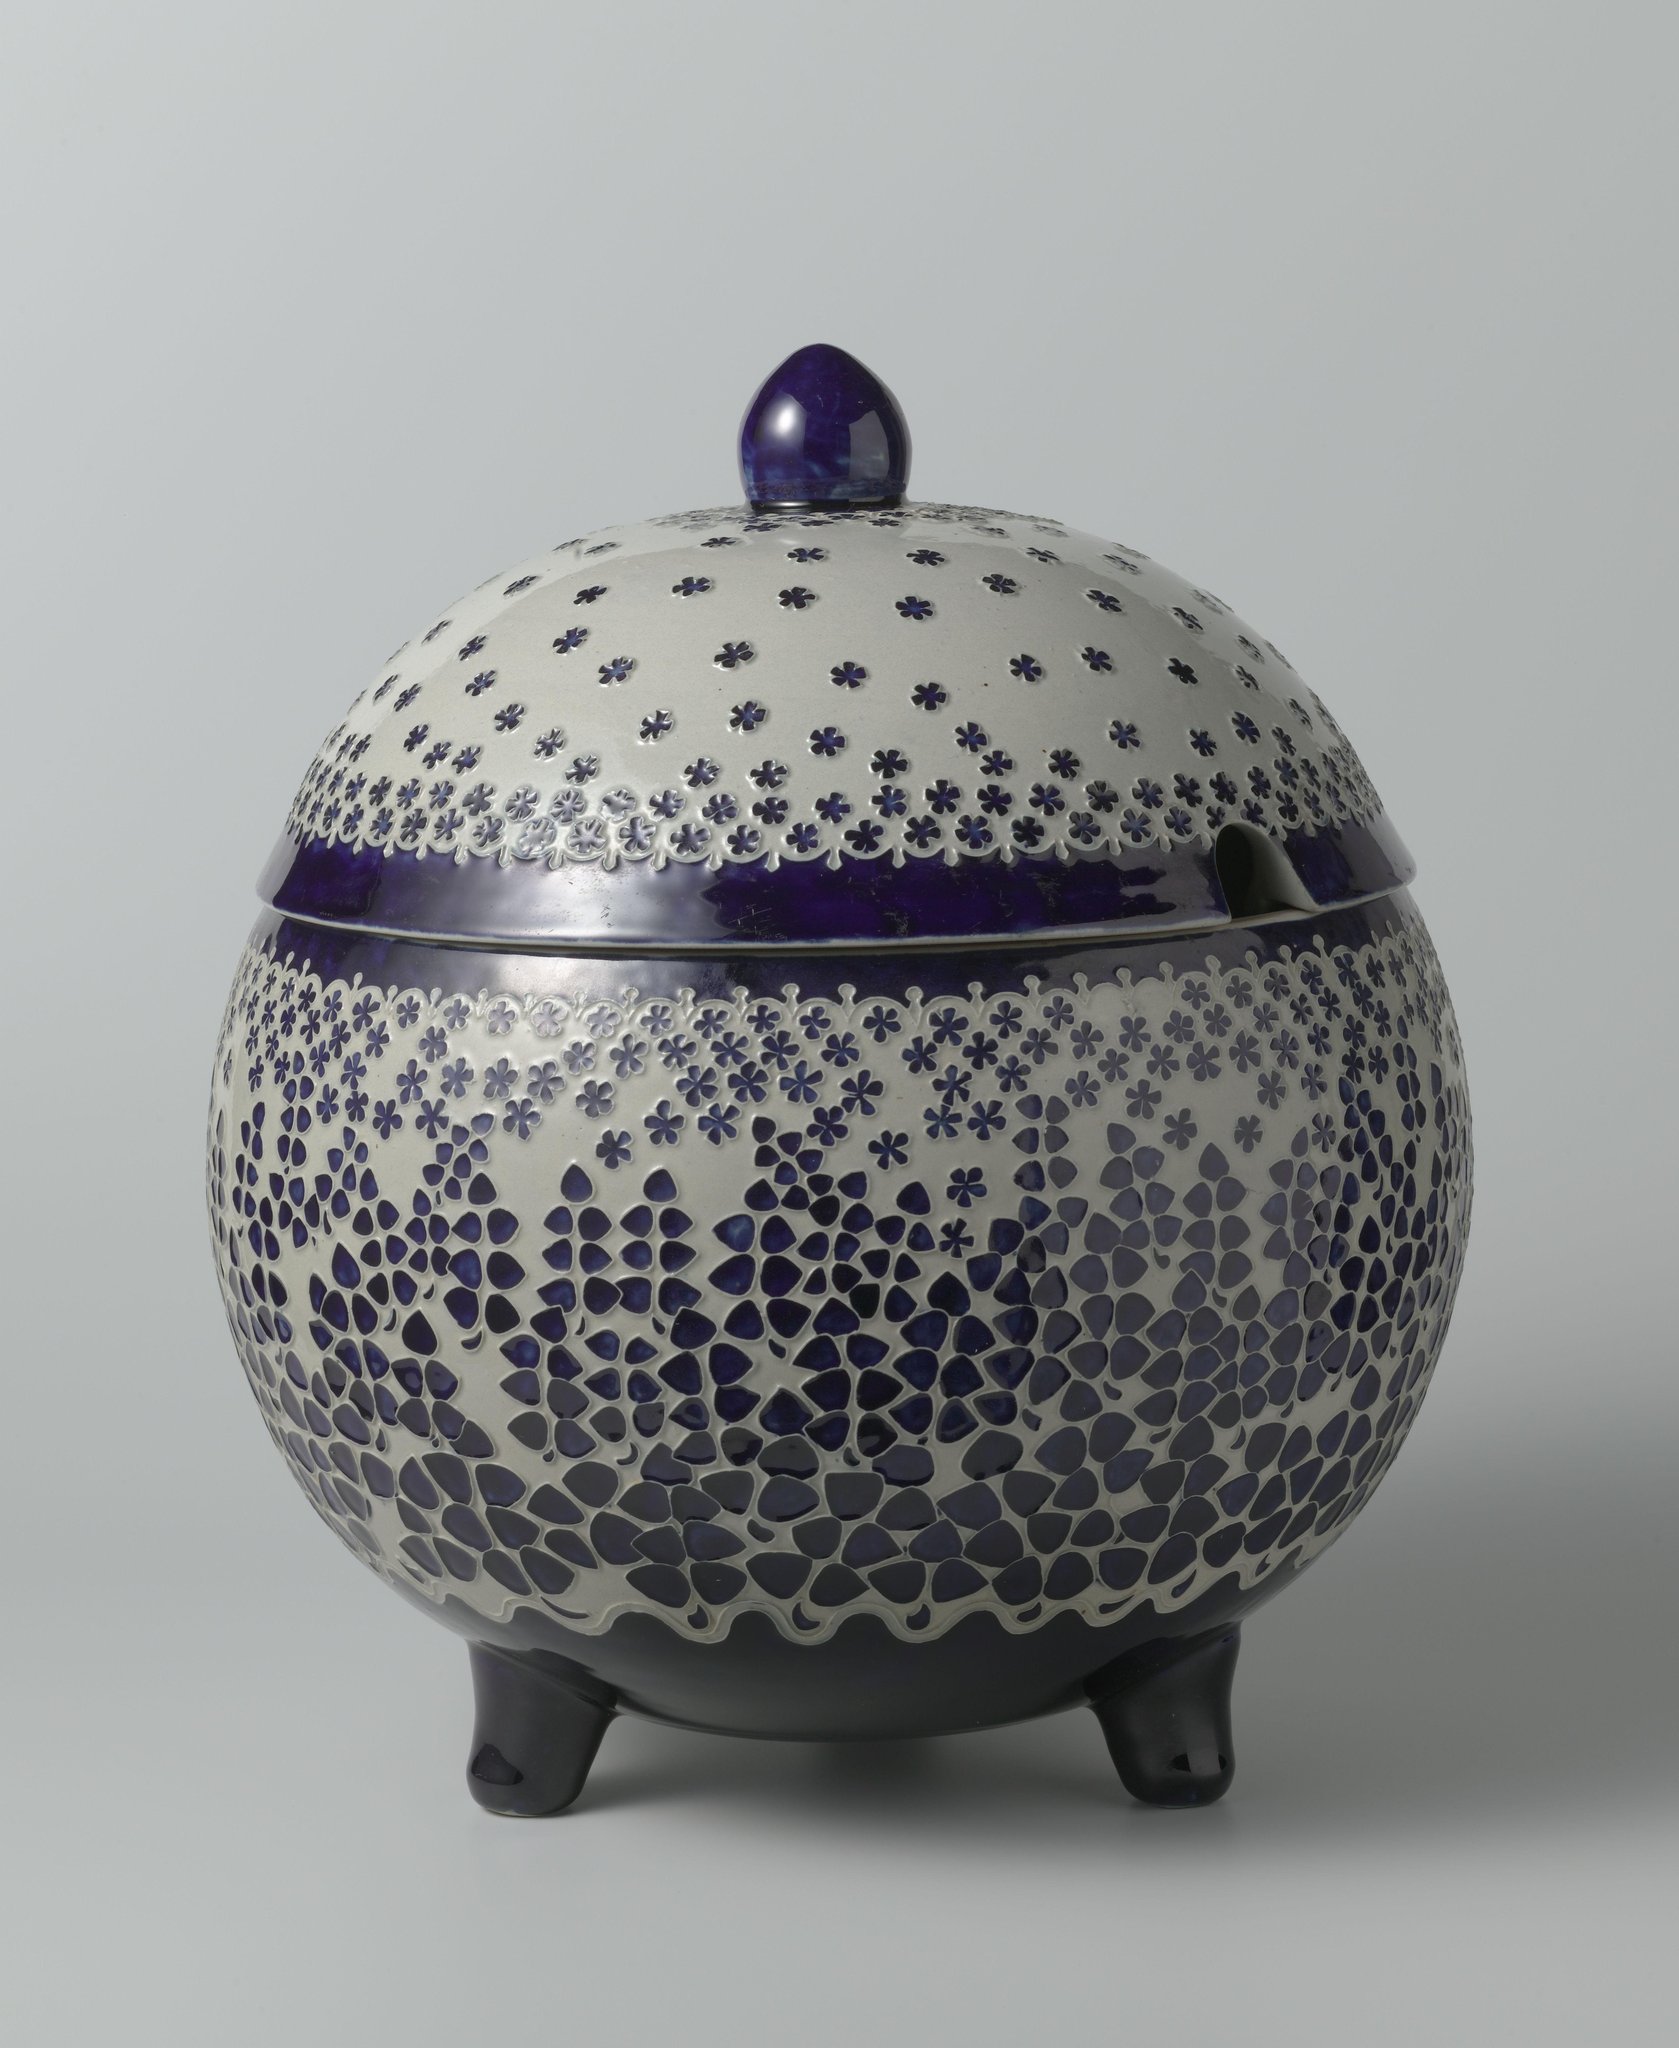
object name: punchkom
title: Punchkom met deksel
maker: richard riemerschmid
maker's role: designer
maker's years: 1868-1957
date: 1902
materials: stoneware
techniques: vitrification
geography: höhr-grenzhausen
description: Bolvormige punchkom met deksel op drie pootjes.